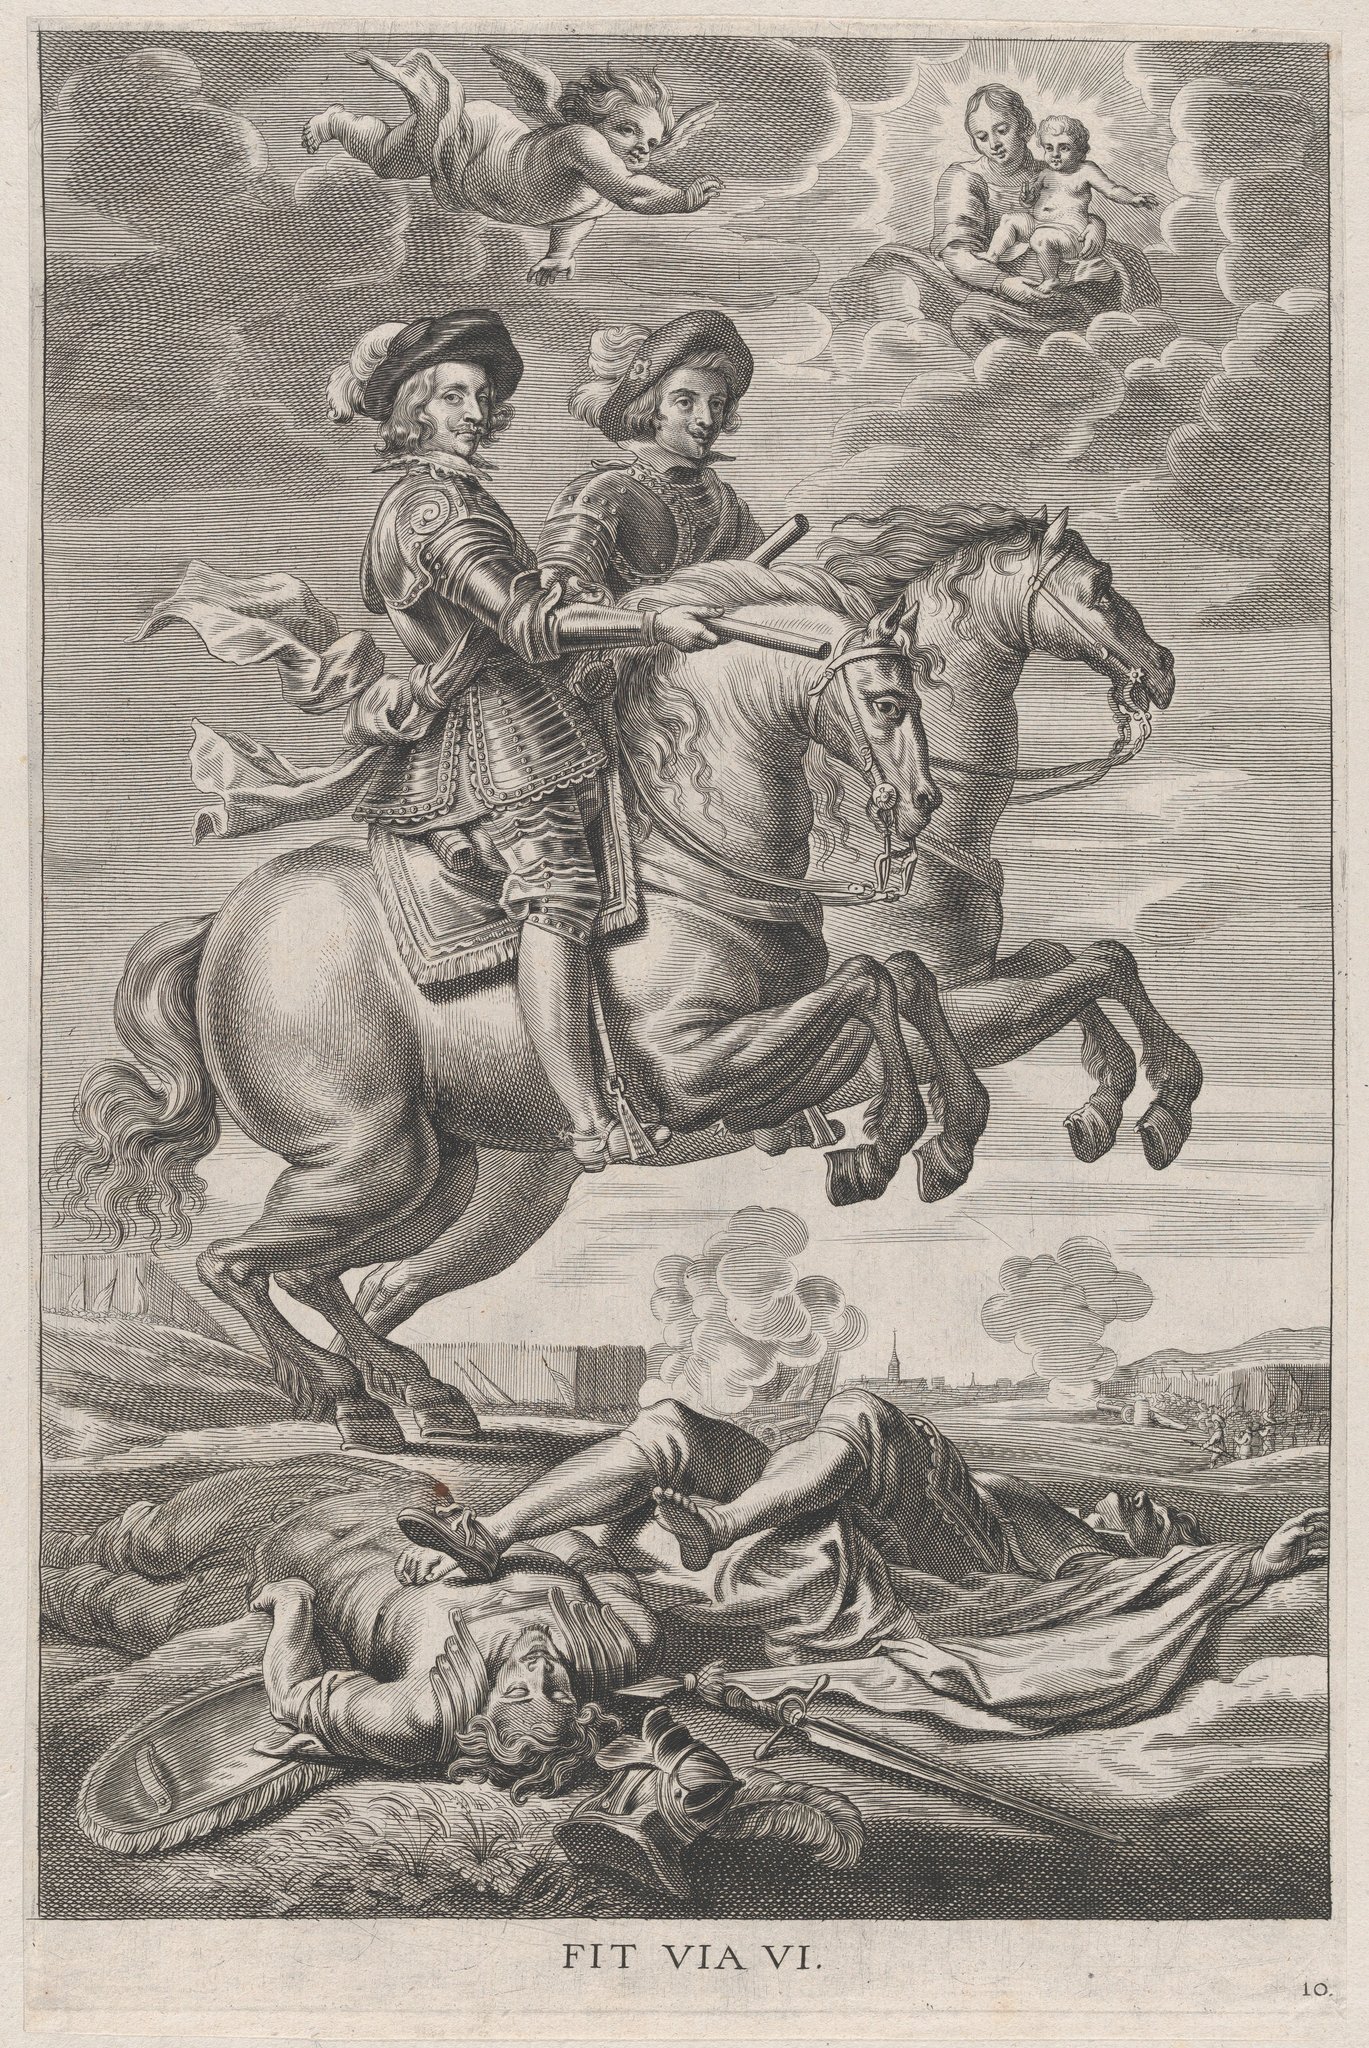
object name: print, fete, ornament architecture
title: Plate 10: The King of Hungary and Ferdinand on horseback; from Guillielmus Becanus's 'Serenissimi Principis Ferdinandi, Hispaniarum Infantis...'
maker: pieter de jode (ii)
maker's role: artist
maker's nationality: flemish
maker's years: 1606-1674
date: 1636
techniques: engraving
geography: antwerp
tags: kings,horses,madonna and child